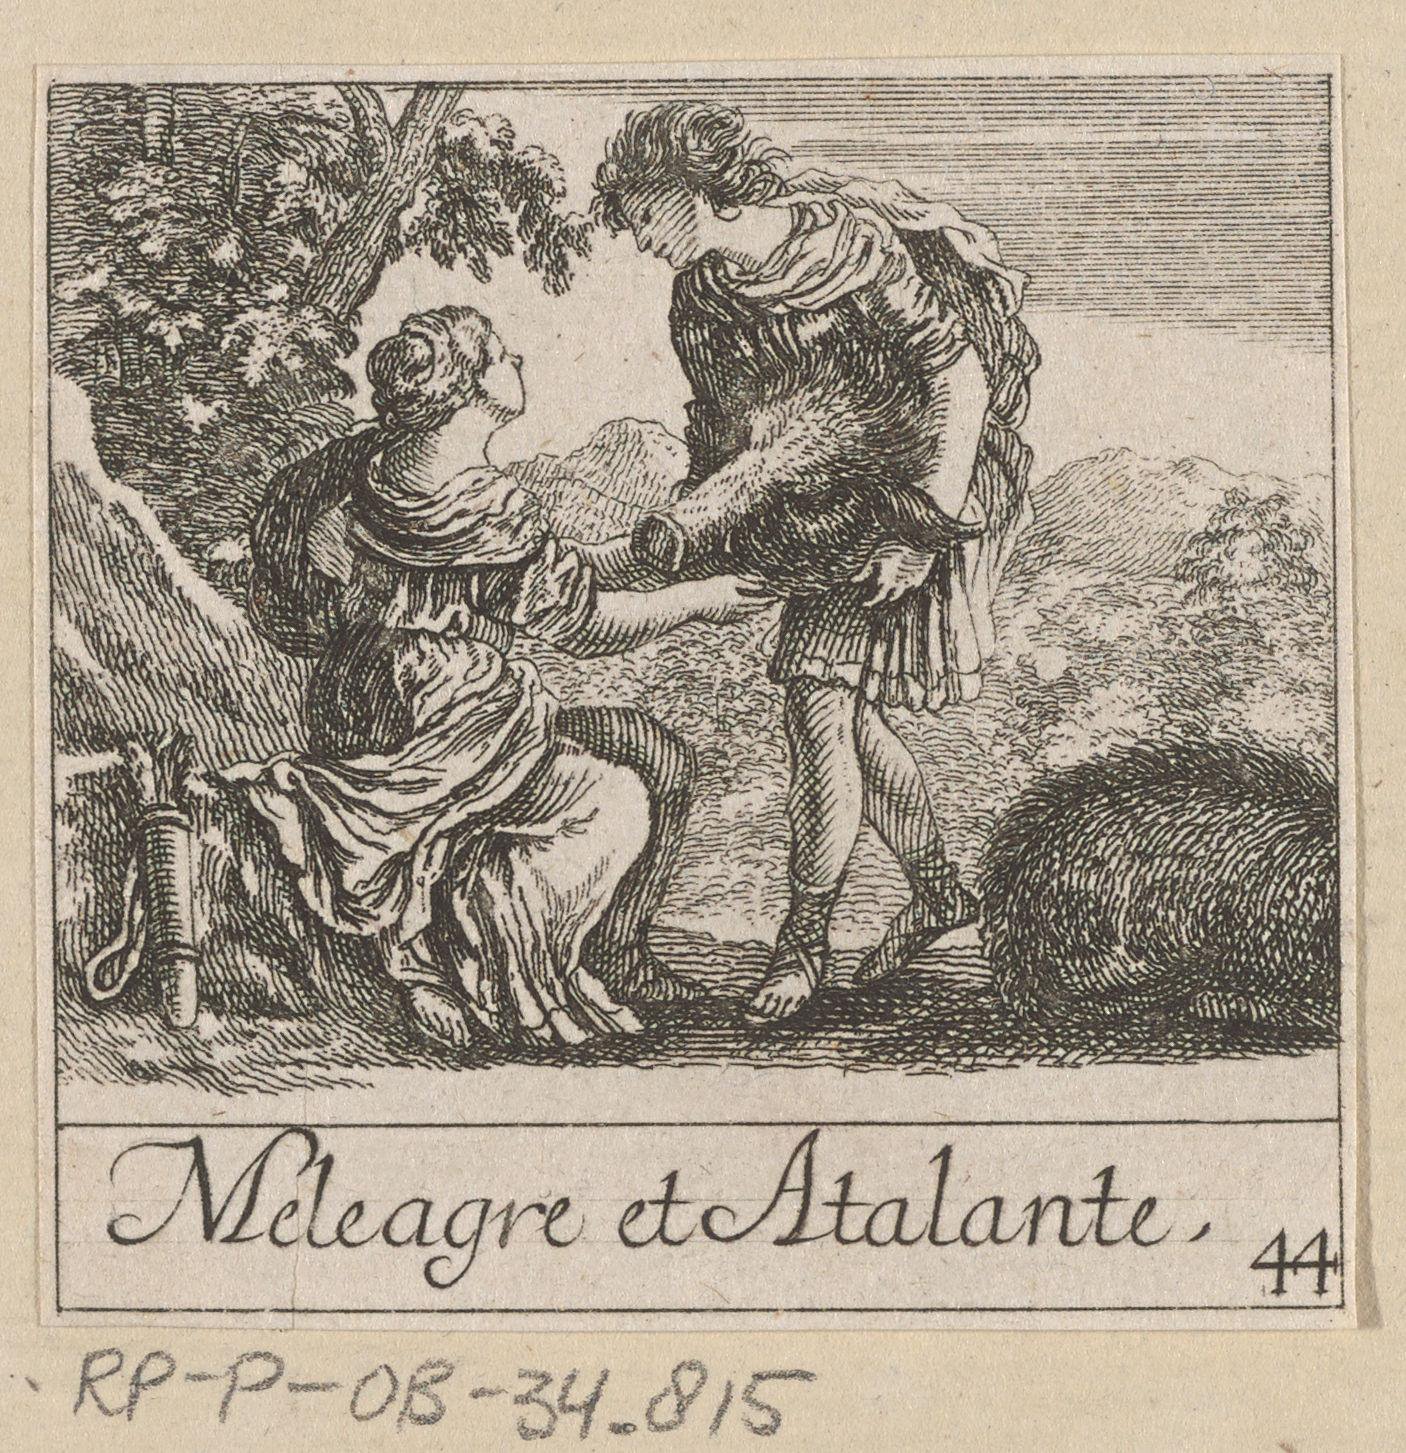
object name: playing card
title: Kaartspel met mythologische voorstellingen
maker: Anonymous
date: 1620-1664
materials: paper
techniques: etching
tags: meleager gives the head of the boar to atalanta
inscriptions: collector's mark: Lugt 240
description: Prent uit een reeks van 54 genummerde speelkaarten met voorstellingen uit de Metamorfosen van Ovidius.